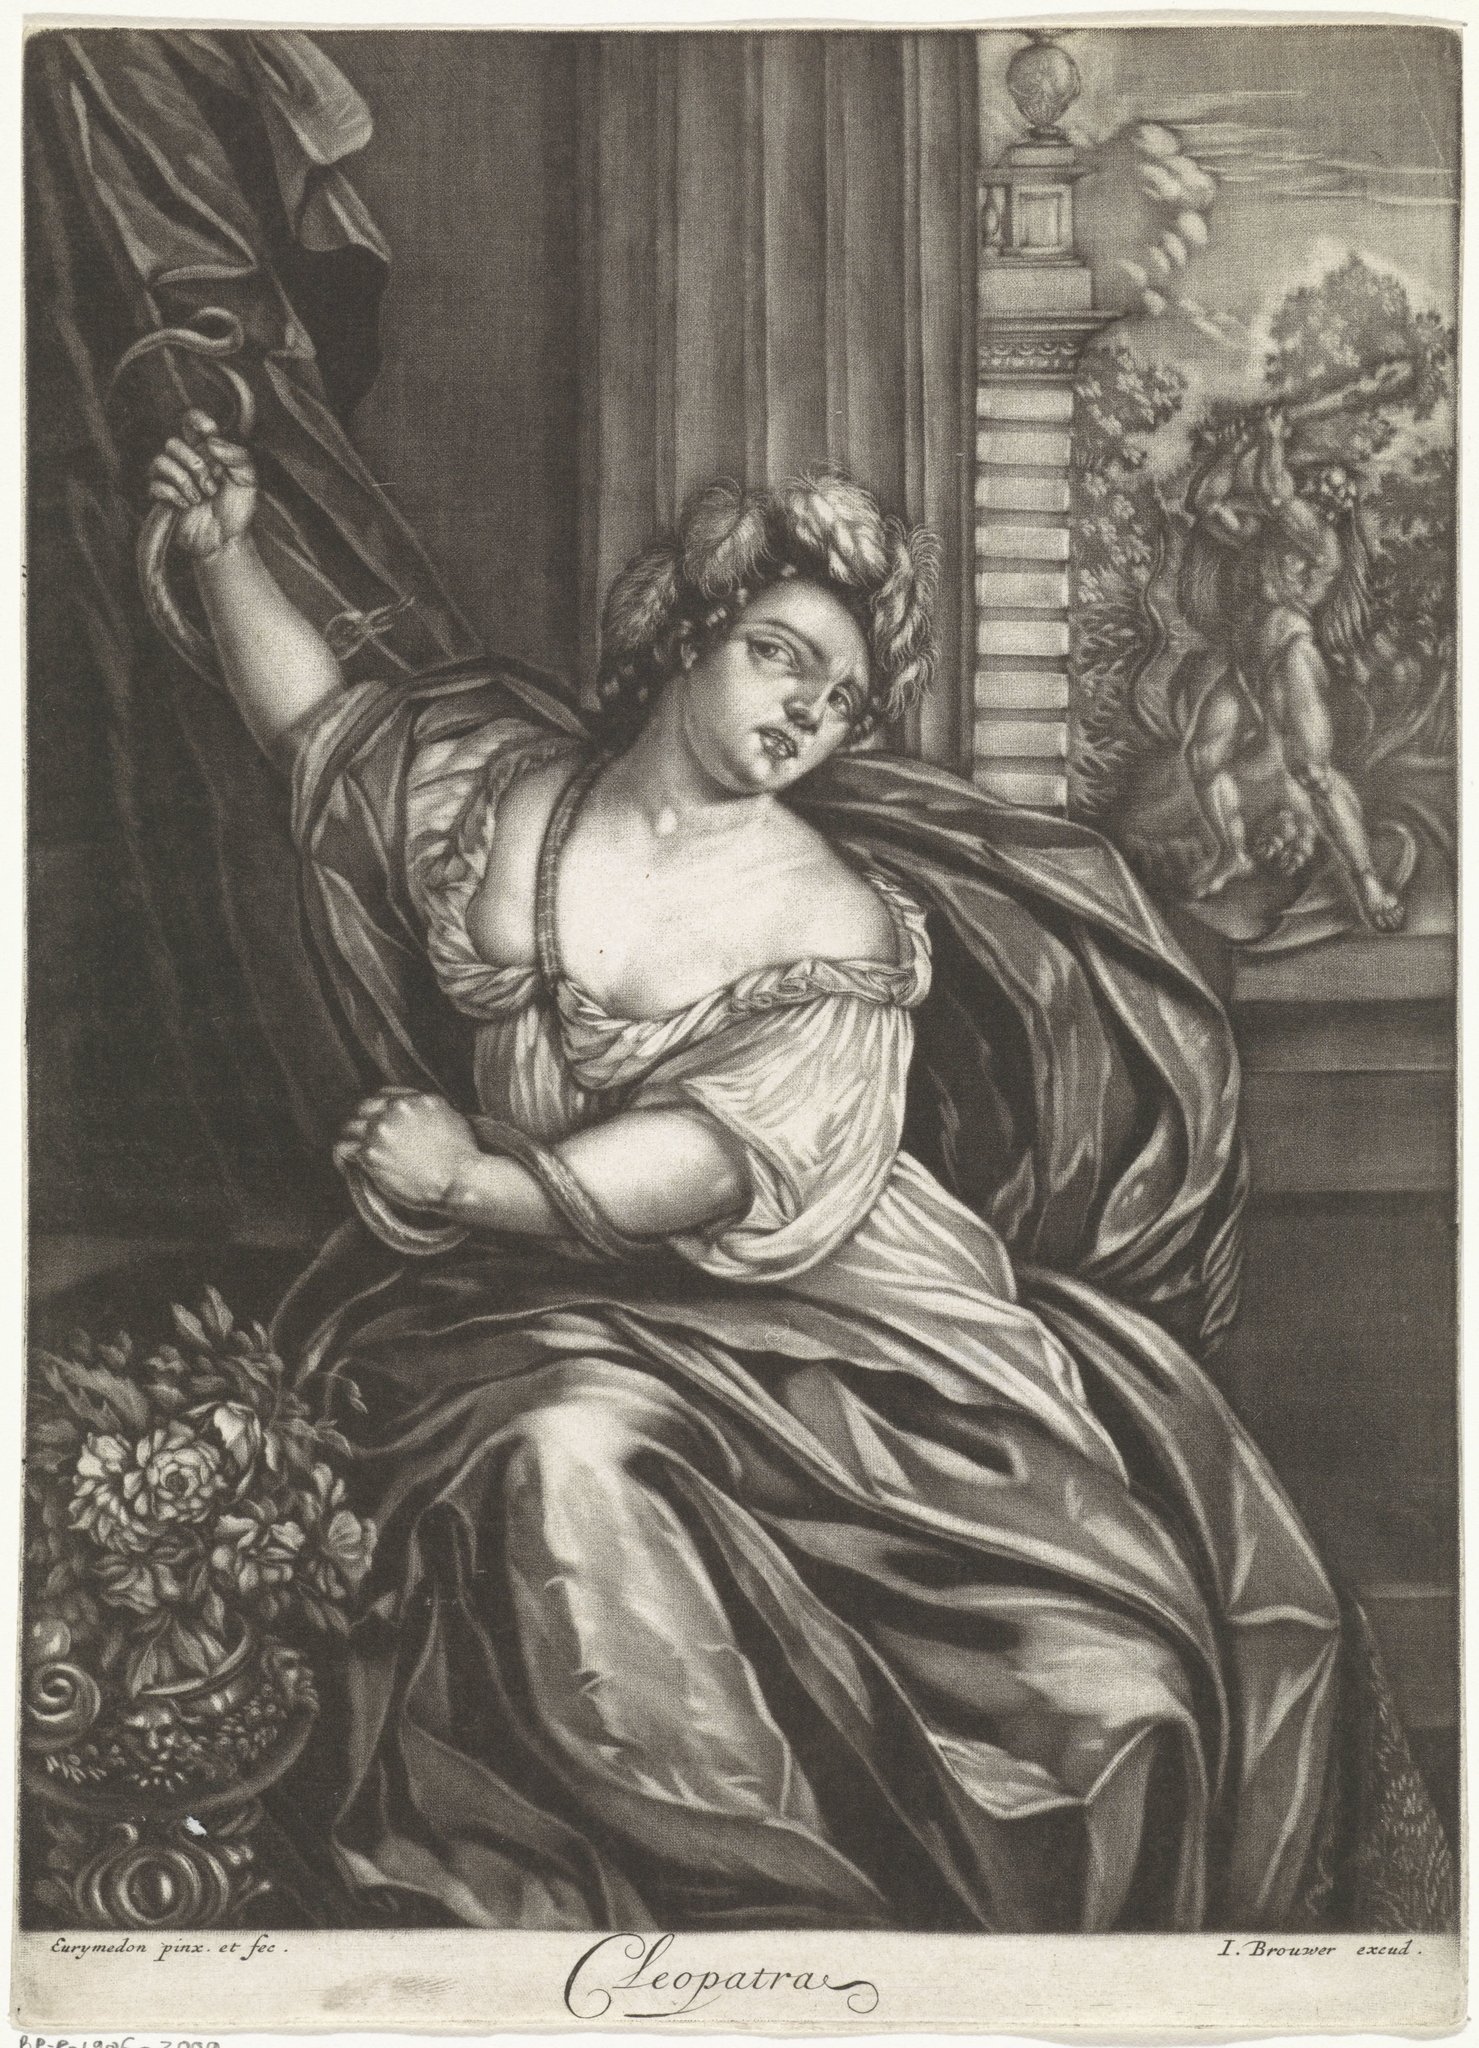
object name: print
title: Cleopatra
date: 1652-1688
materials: paper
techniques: engraving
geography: amsterdam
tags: (story of) cleopatra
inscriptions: collector's mark: Lugt 2228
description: Cleopatra, koningin van Egypte, maakt een eind aan haar leven door zich te laten bijten door een giftige slang. In haar handen twee slangen. Ze besluit de hand aan zichzelf te slaan omdat ze niet gevangen wil worden door de Romeinen.